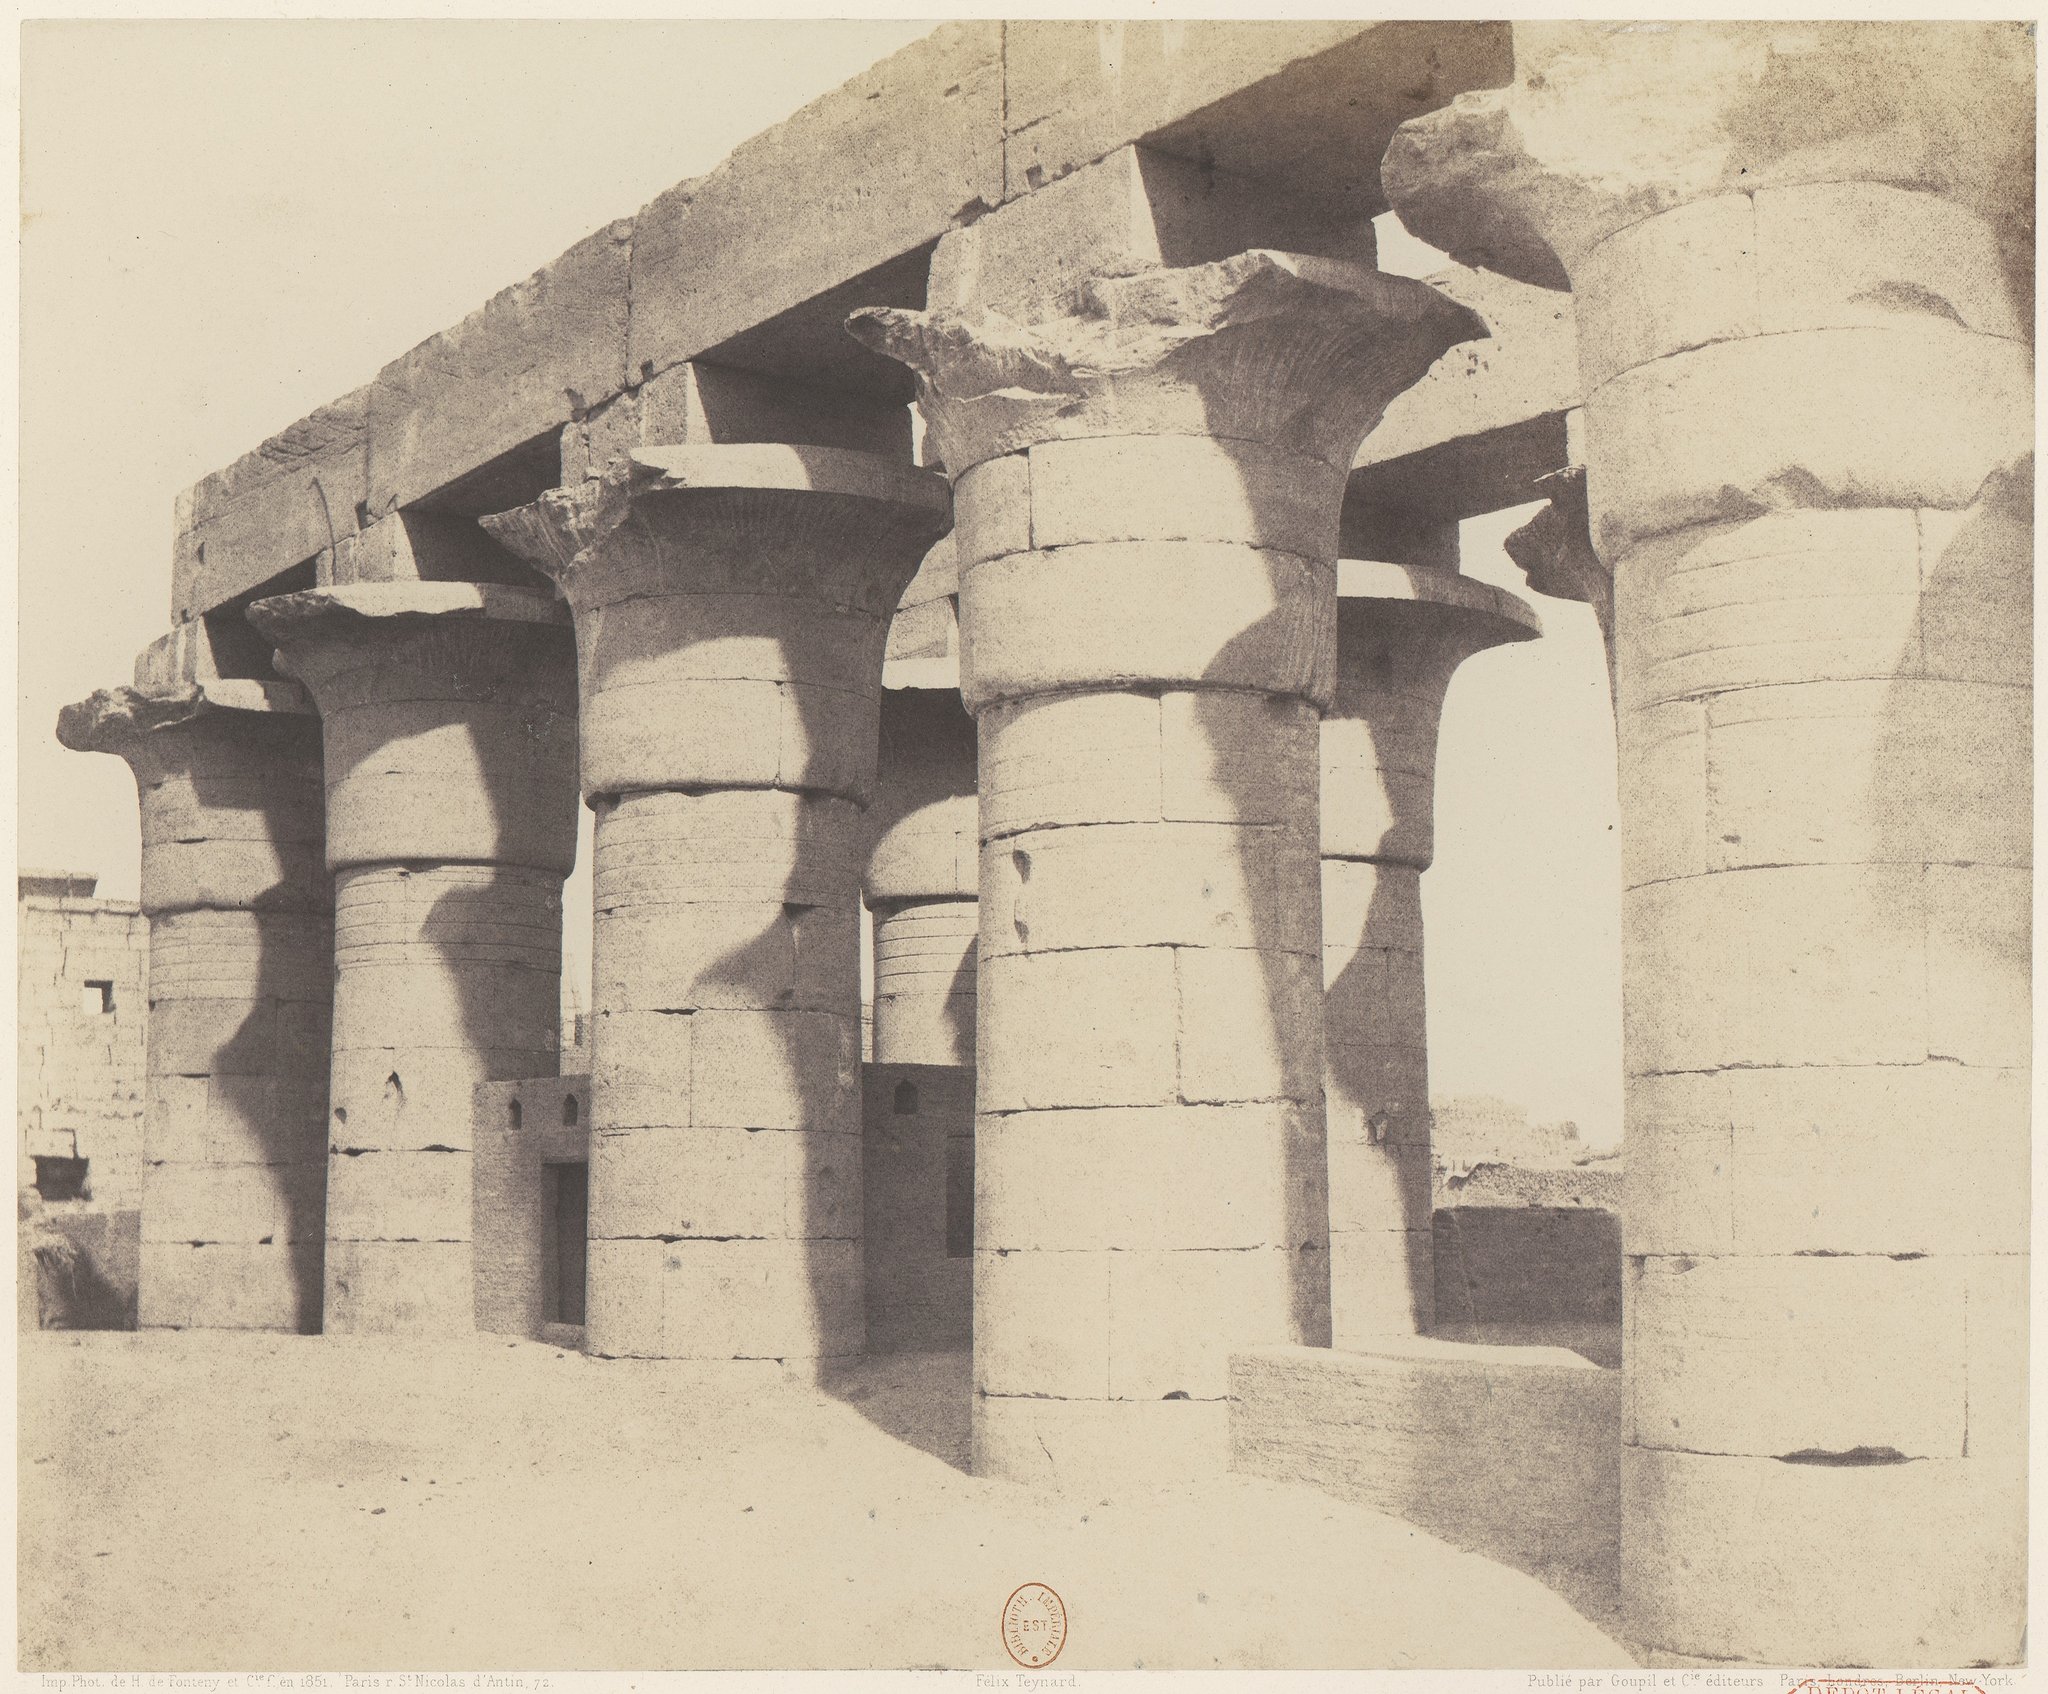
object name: photograph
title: Louksor (Thèbes). Construction Centrale - Grande Colonnade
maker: félix teynard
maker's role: artist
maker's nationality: french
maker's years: 1817-1892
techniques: paper negative, salted paper print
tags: columns,ruins